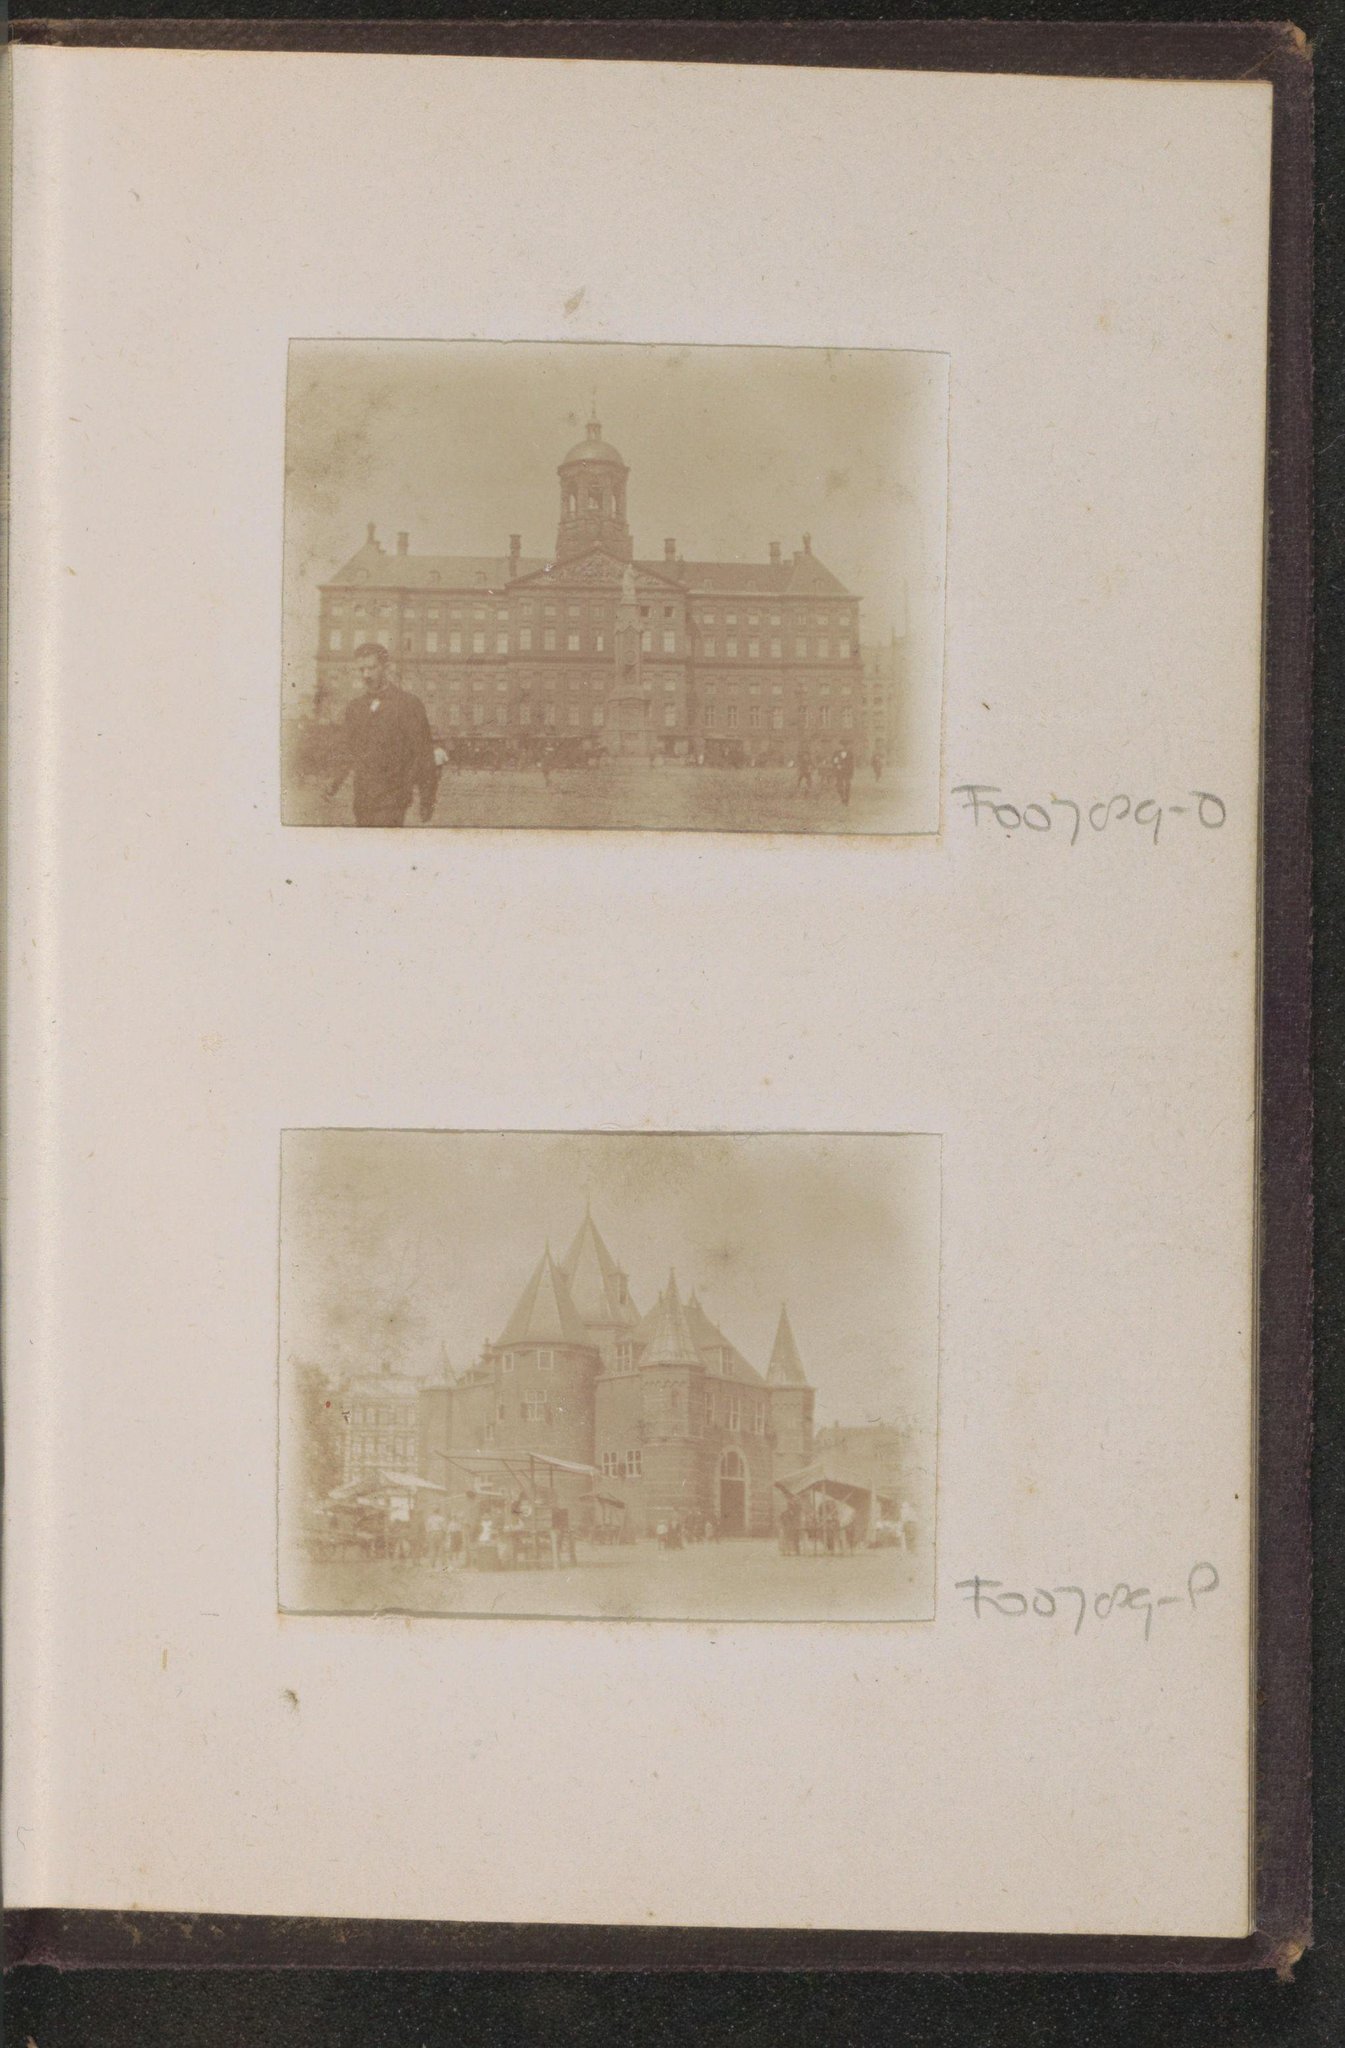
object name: contact print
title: Marktkramen voor het Waaggebouw op de Nieuwmarkt in Amsterdam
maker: Anonymous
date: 1880-1900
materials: paper, photographic support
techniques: collodion silver print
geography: nieuwmarkt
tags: market, weigh-house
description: Onderdeel van Fotoalbum met 35 foto's van Amsterdam, personen en dieren.